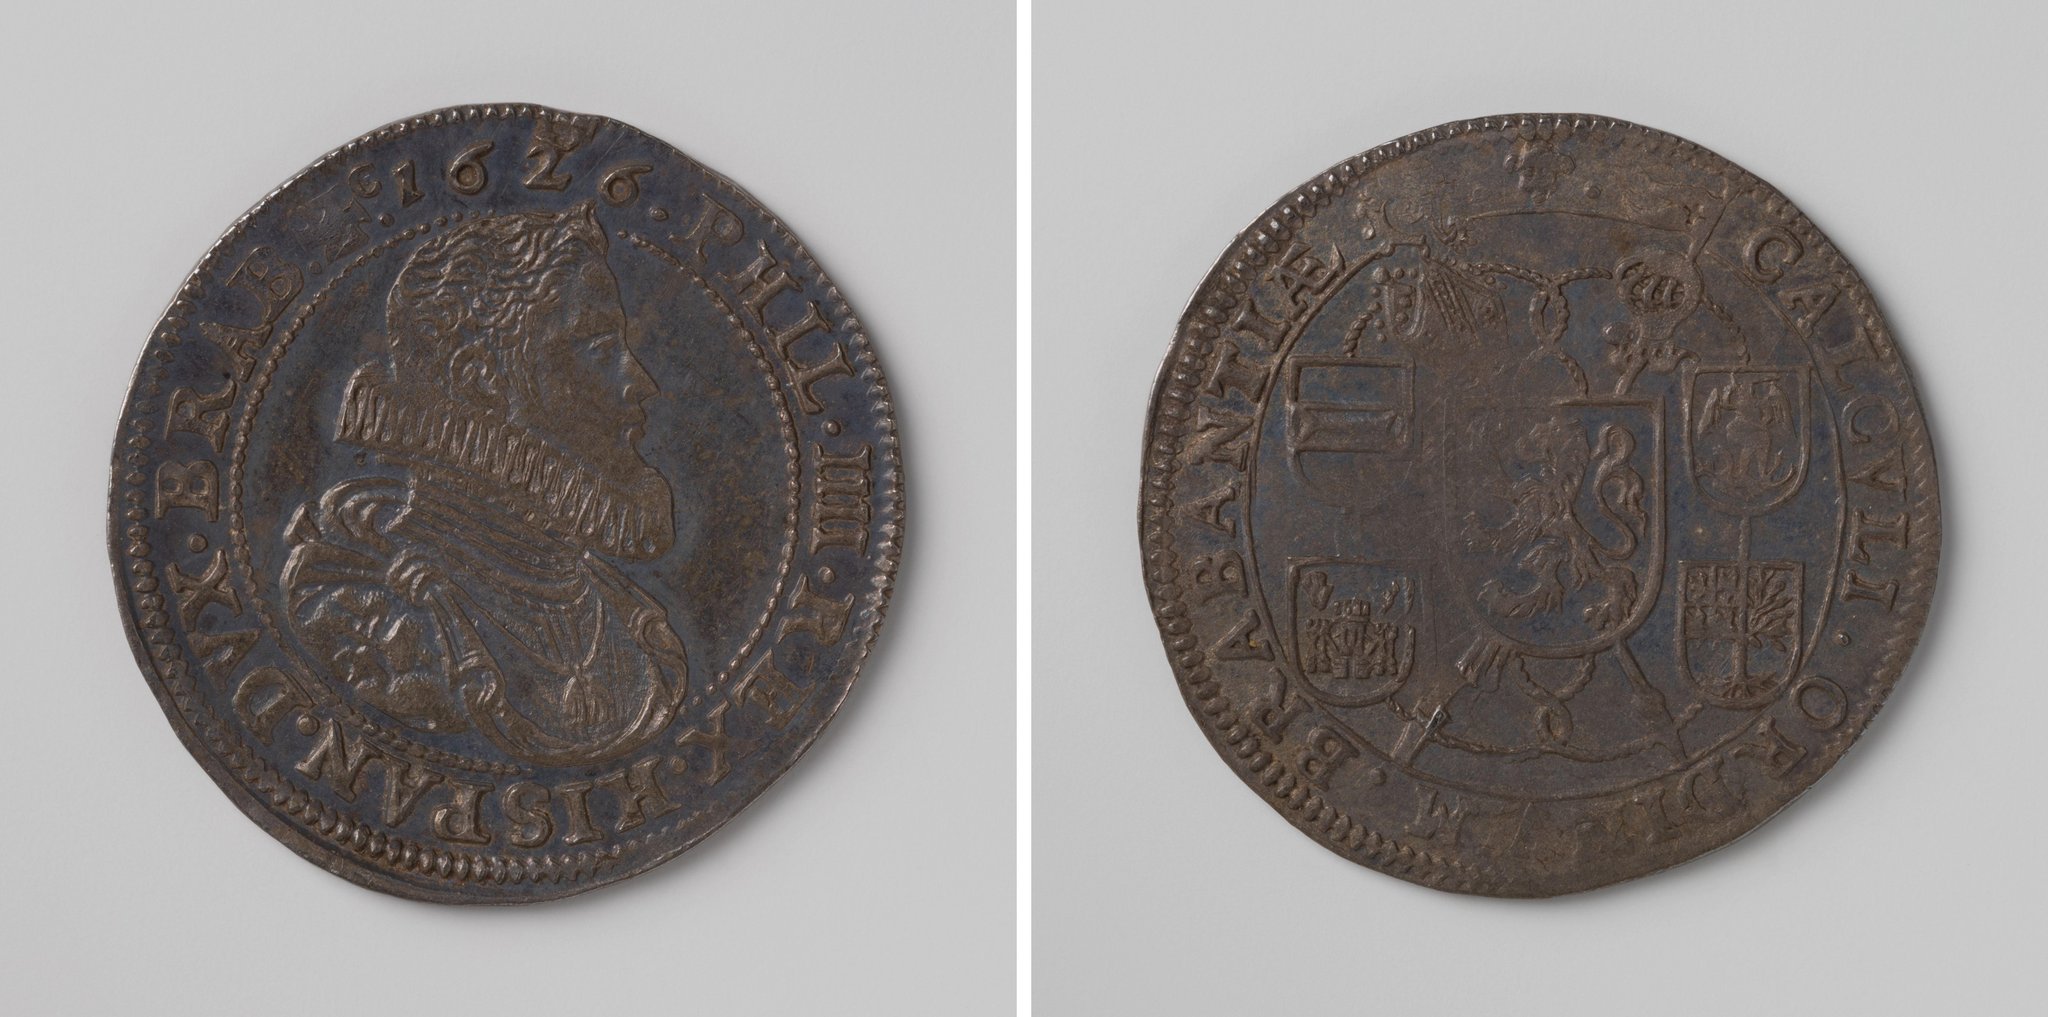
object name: jeton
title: Filips IV, koning van Spanje, rekenpenning geslagen op last van de Staten van Brabant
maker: Anonymous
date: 1626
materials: silver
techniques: striking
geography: brussels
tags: filips iv (koning van spanje), brabant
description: Zilveren penning. Voorzijde: borststuk man binnen omschrift. Keerzijde: wapenschild op een gekruiste bisschopsstaf, bekroond met een mijter, en een lans, bekroond met een helm, omgeven door vier met koord samengebonden wapenschilden binnen omschrift